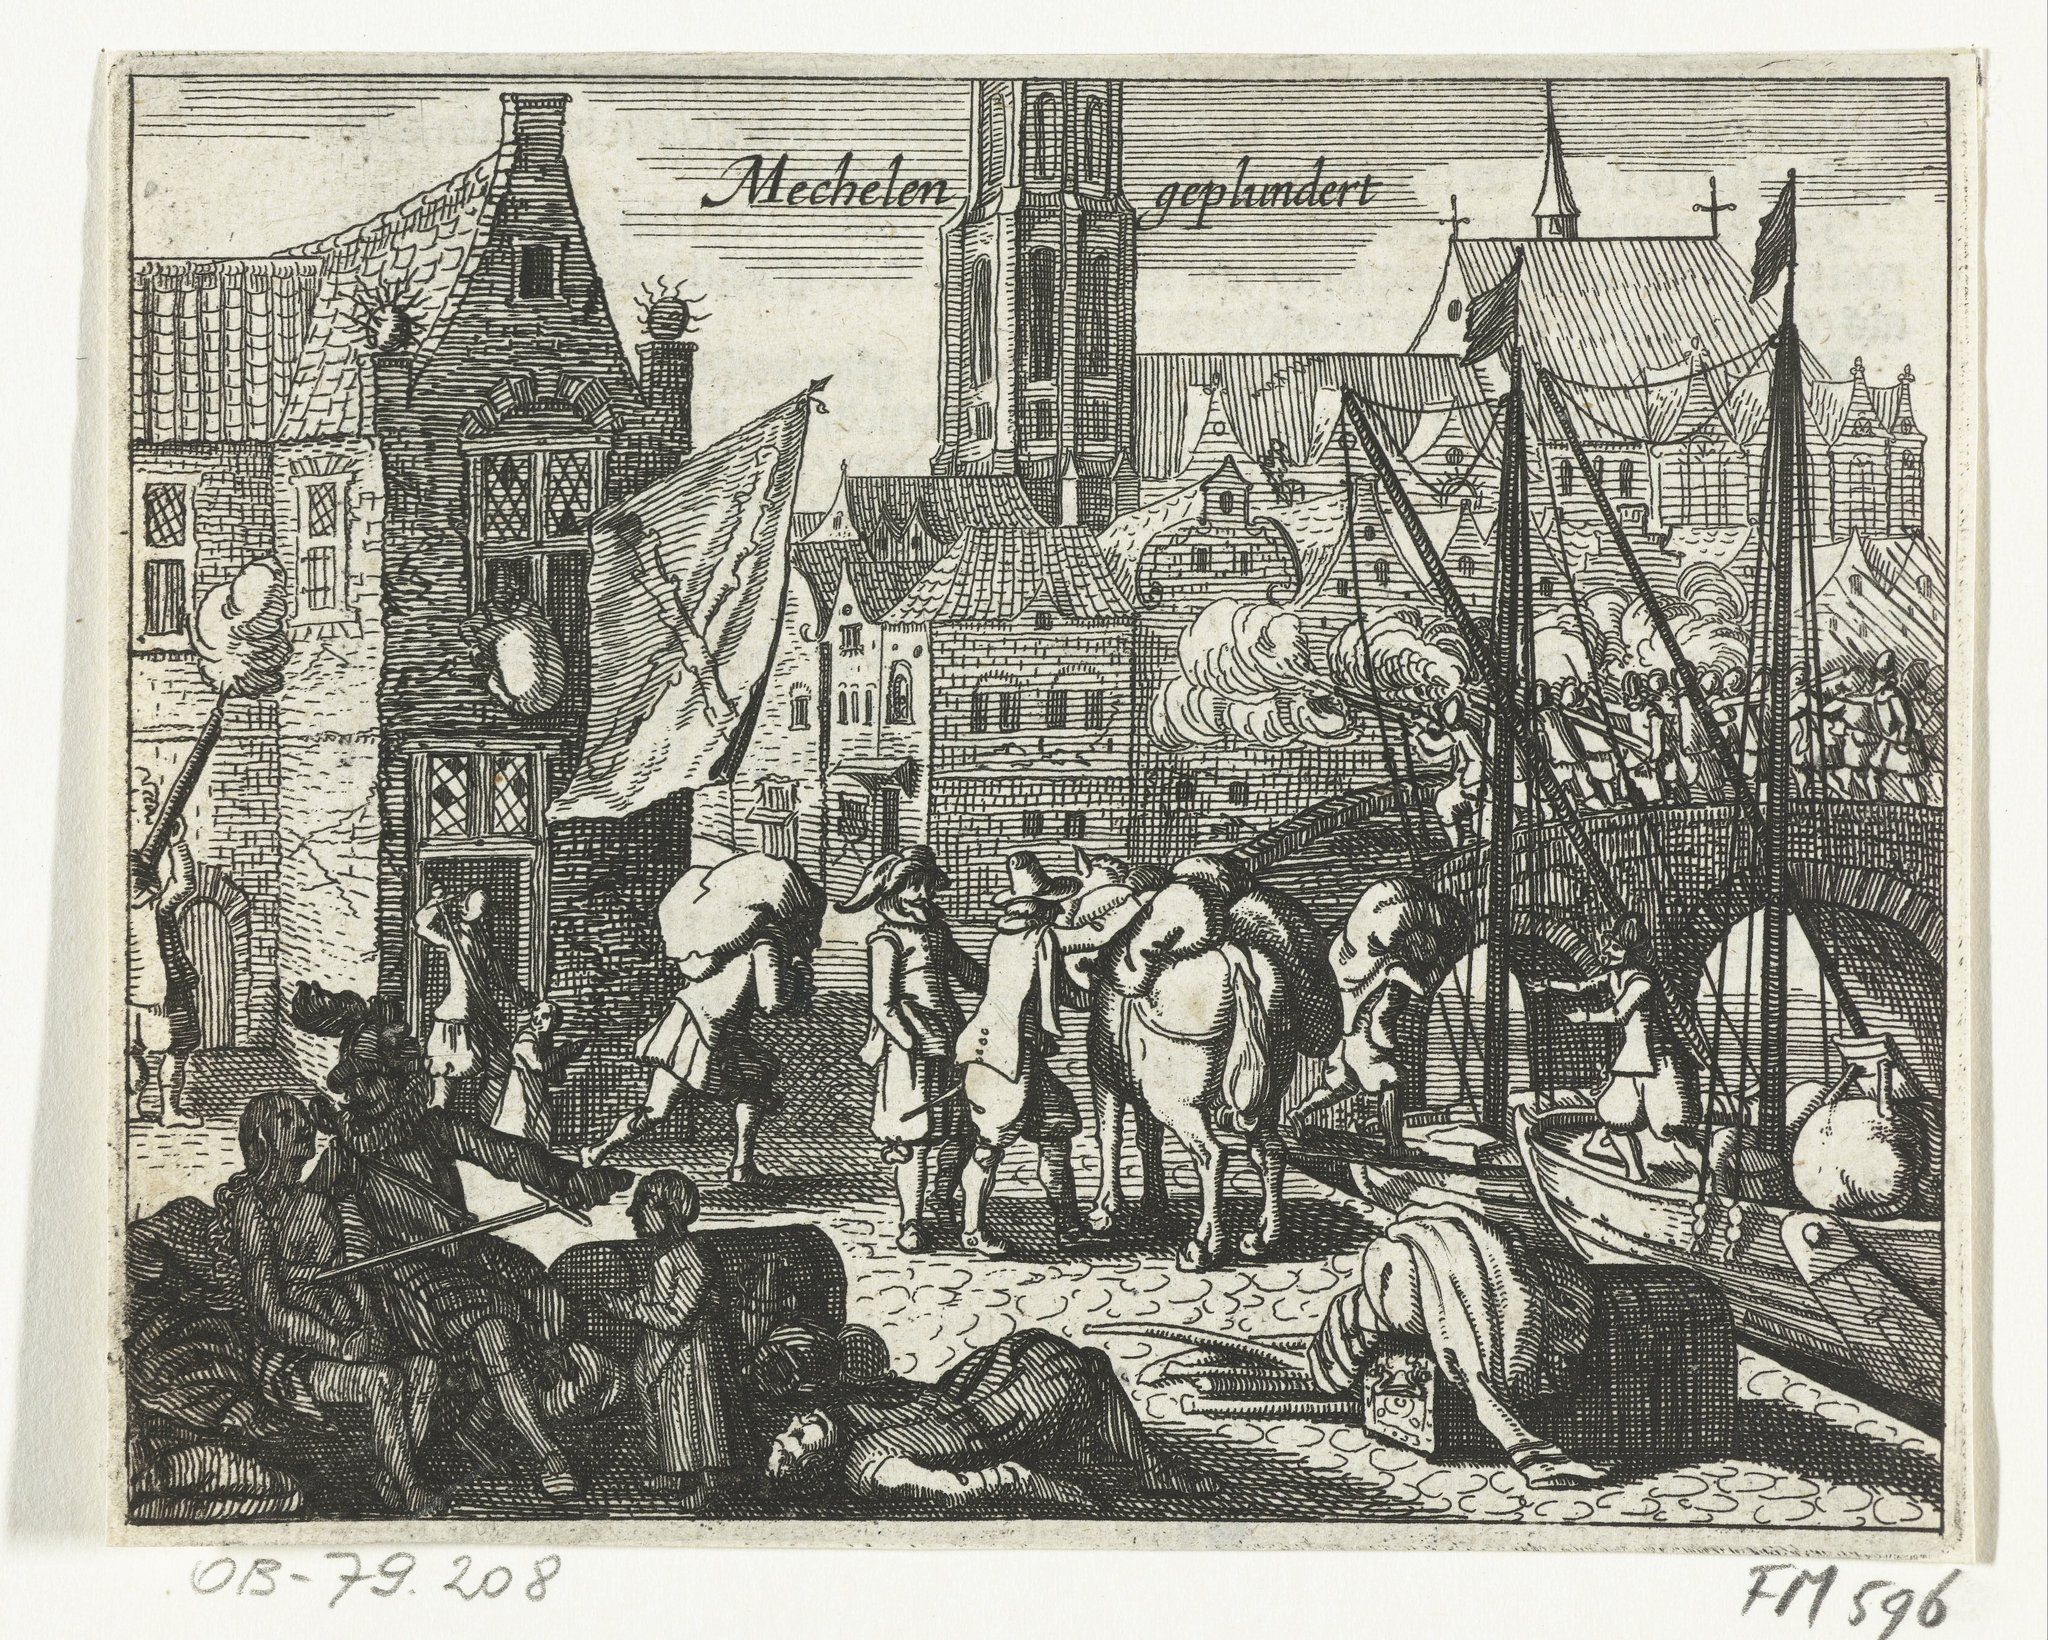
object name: print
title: Plundering van Mechelen, 1572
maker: Anonymous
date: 1619-1621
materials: paper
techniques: etching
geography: northern netherlands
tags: plundering ~ soldiers, mechelen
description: Illustratie afkomstig uit: De spaansche tiranije gheschiet in Neder-lant waer in te sien is de onmenschelicke ende wreede handelingen der Spaengiaerden ... ooc de moort van den ... prince van Orangnien, ende grave van den Broeck, 1621 te Amsterdam bij C.L. vander Plasse, fig. 9, p. 40 (in de collectie van de Rijksmuseum Research Library, signatuur 327 K 30).